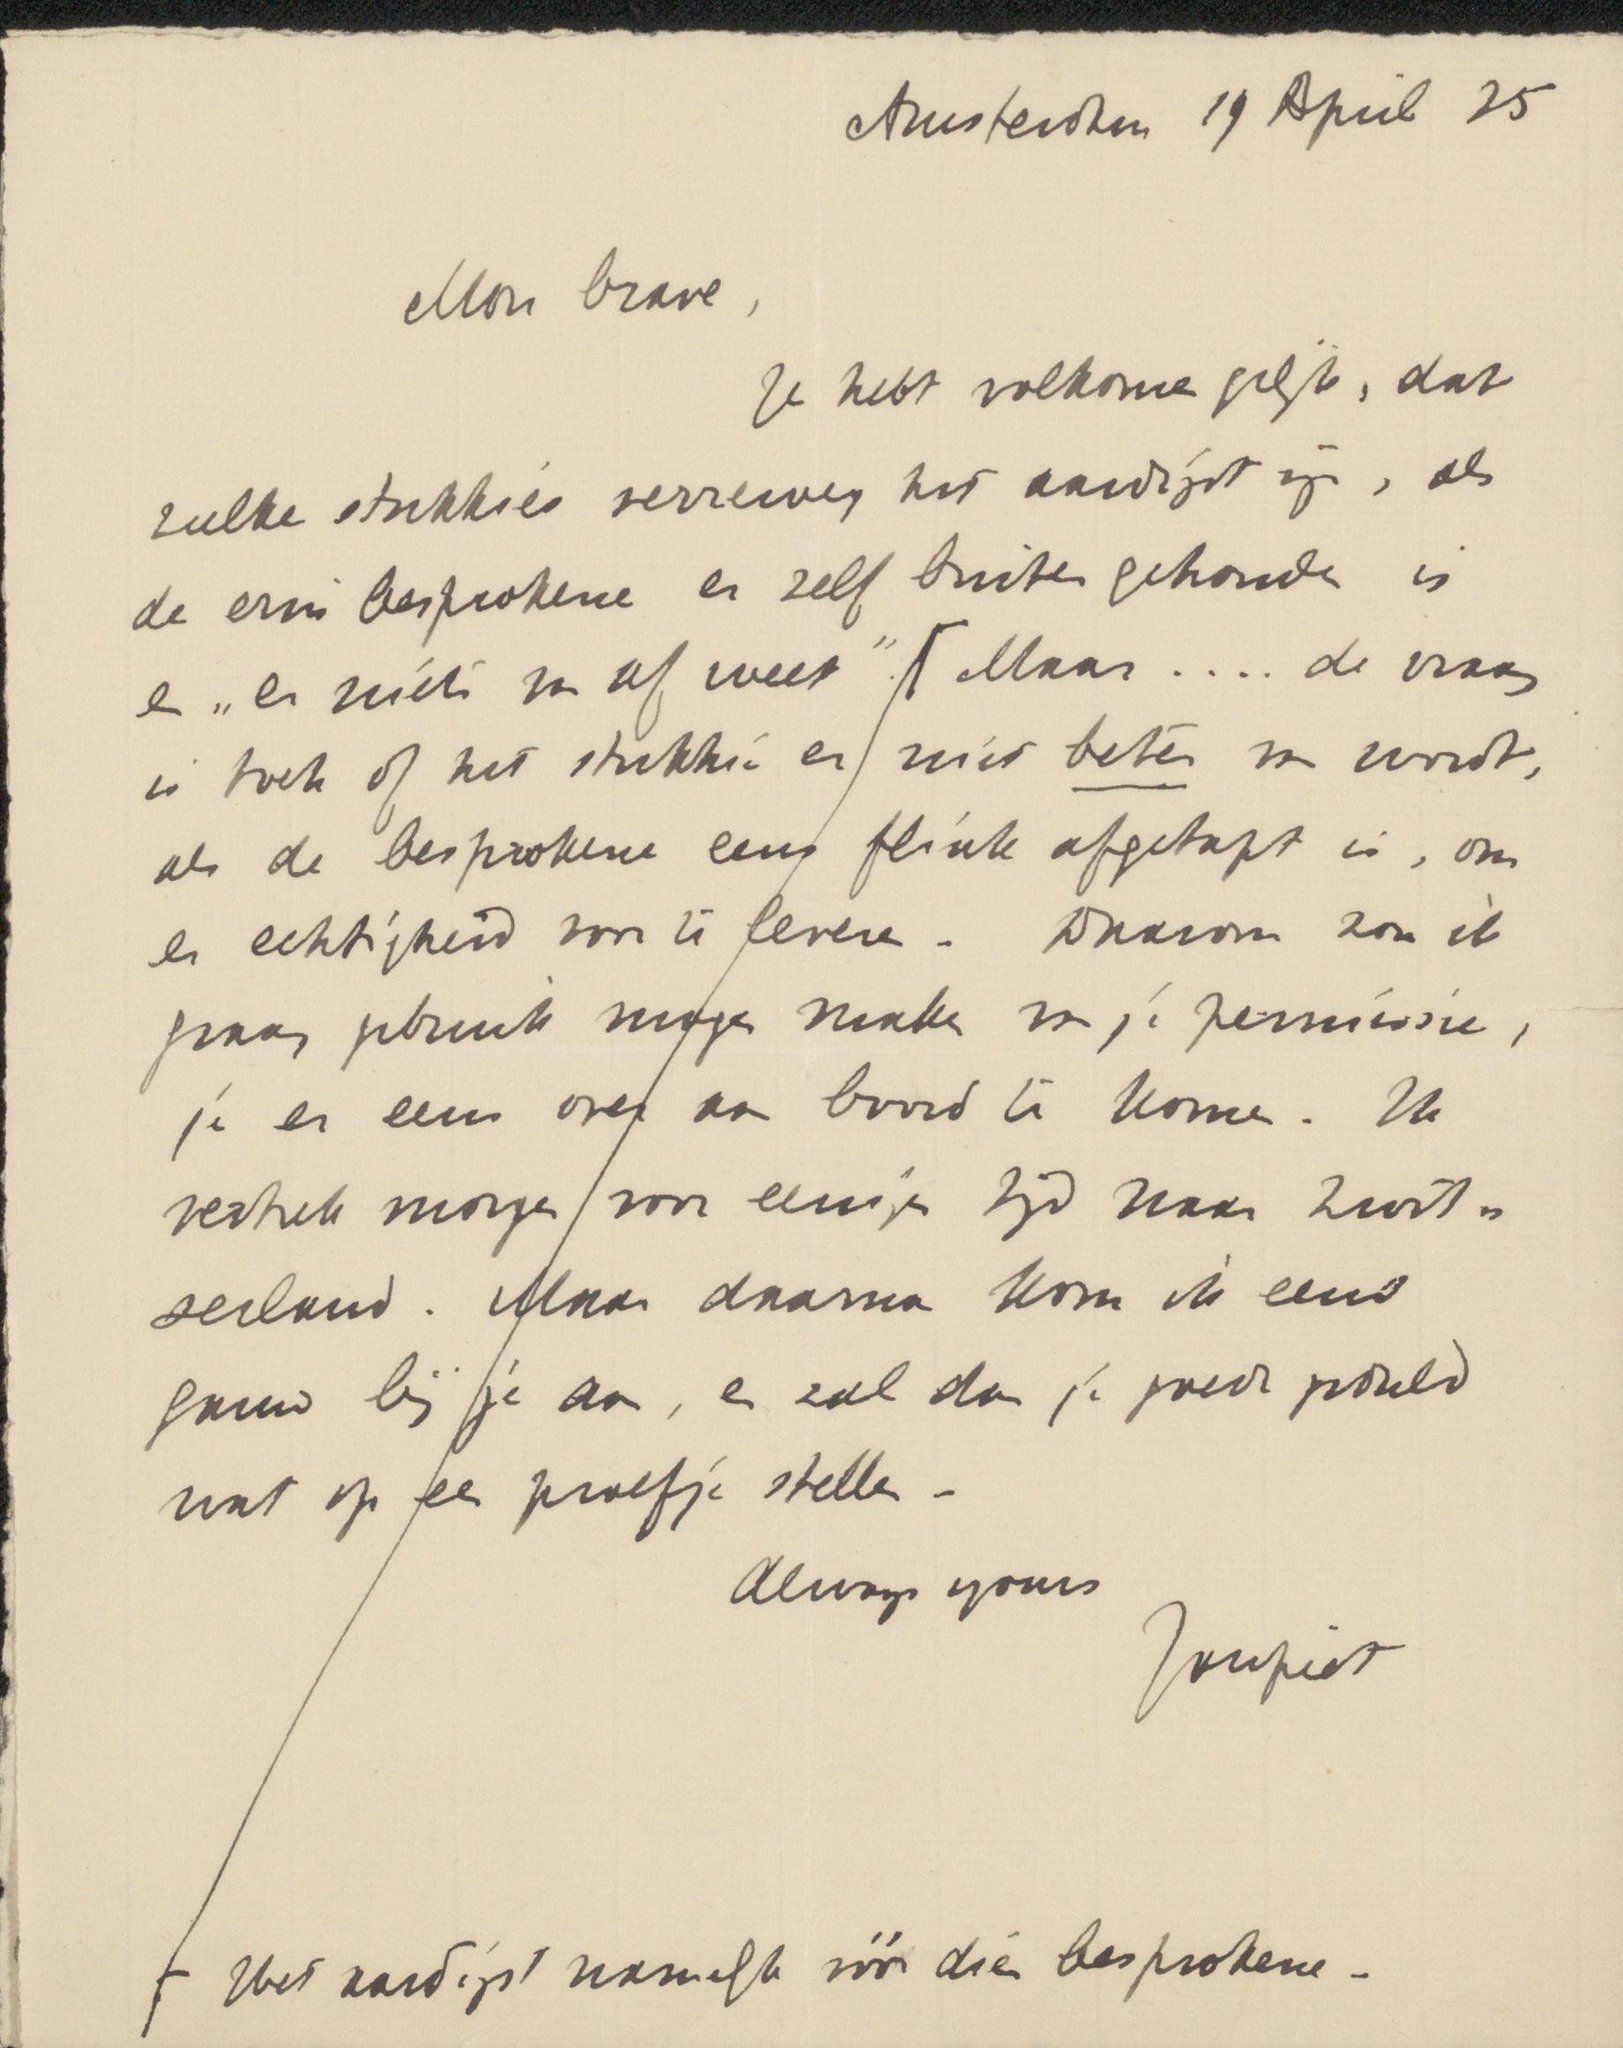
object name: letter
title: Brief aan Isaac Israels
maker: jan veth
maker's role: designer, draughtsman, painter, print maker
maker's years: 1864-1925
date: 1925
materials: ink, paper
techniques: pen, writing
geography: amsterdam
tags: amsterdam, painter, print maker, draughtsman, isaac israels, printed matter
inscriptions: collector's mark: ‘RPK’